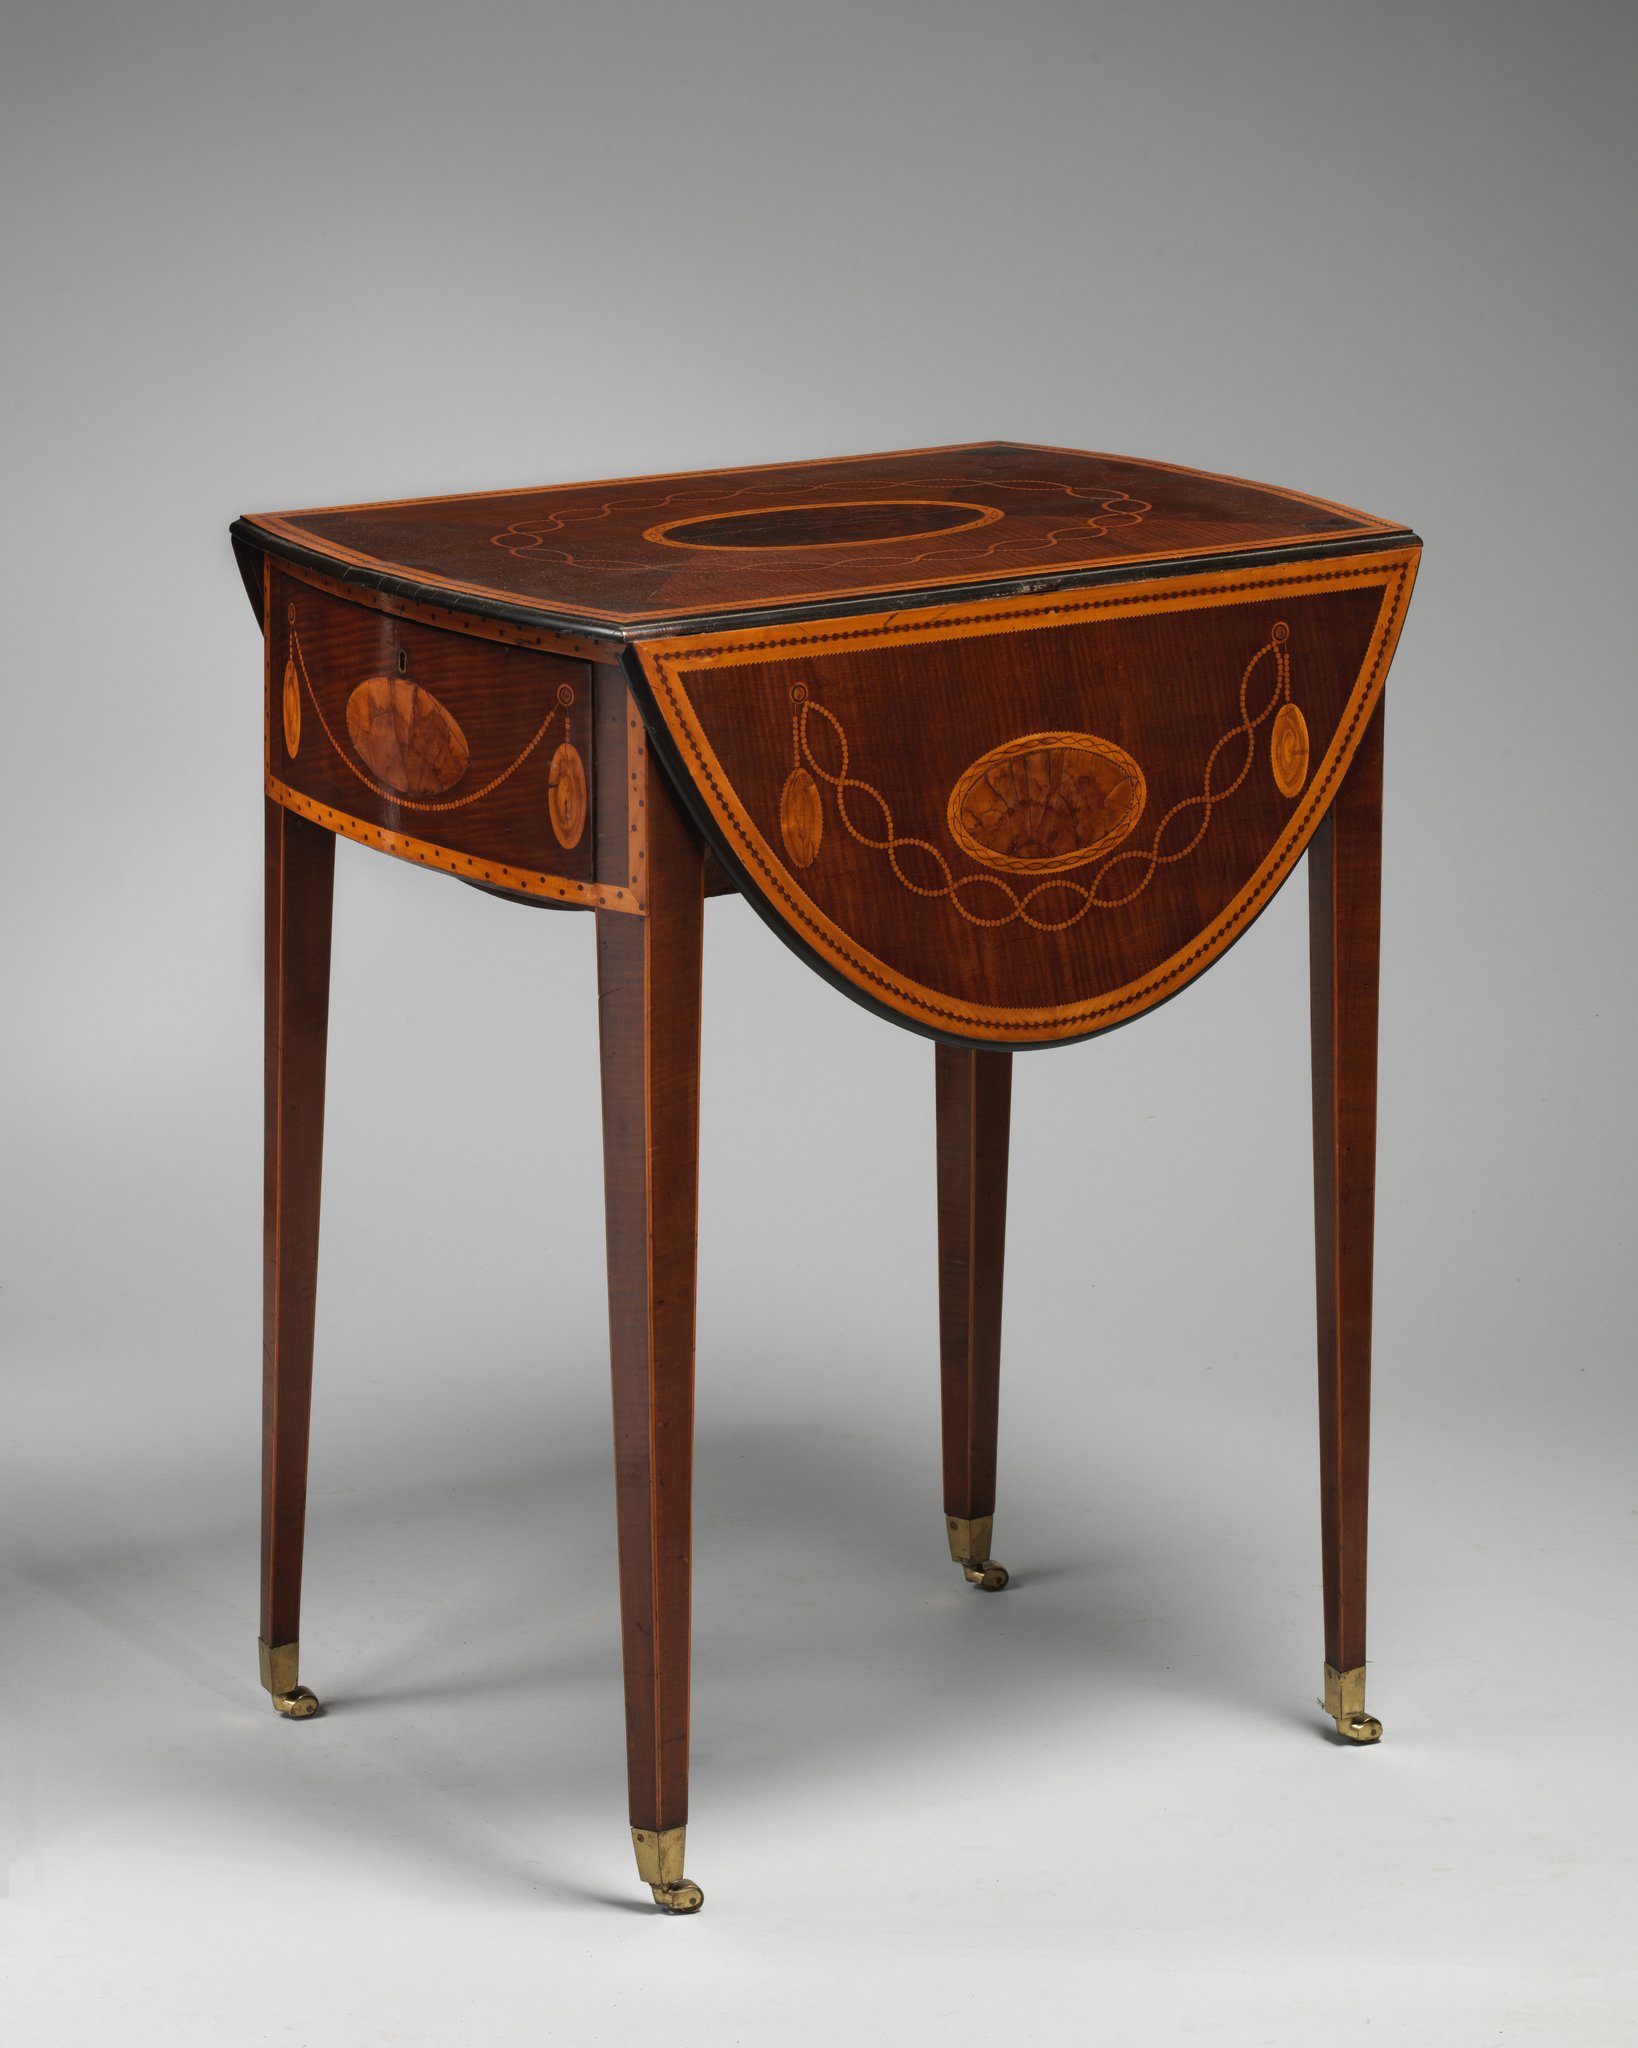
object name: pembroke table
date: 1790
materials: wood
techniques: veneering